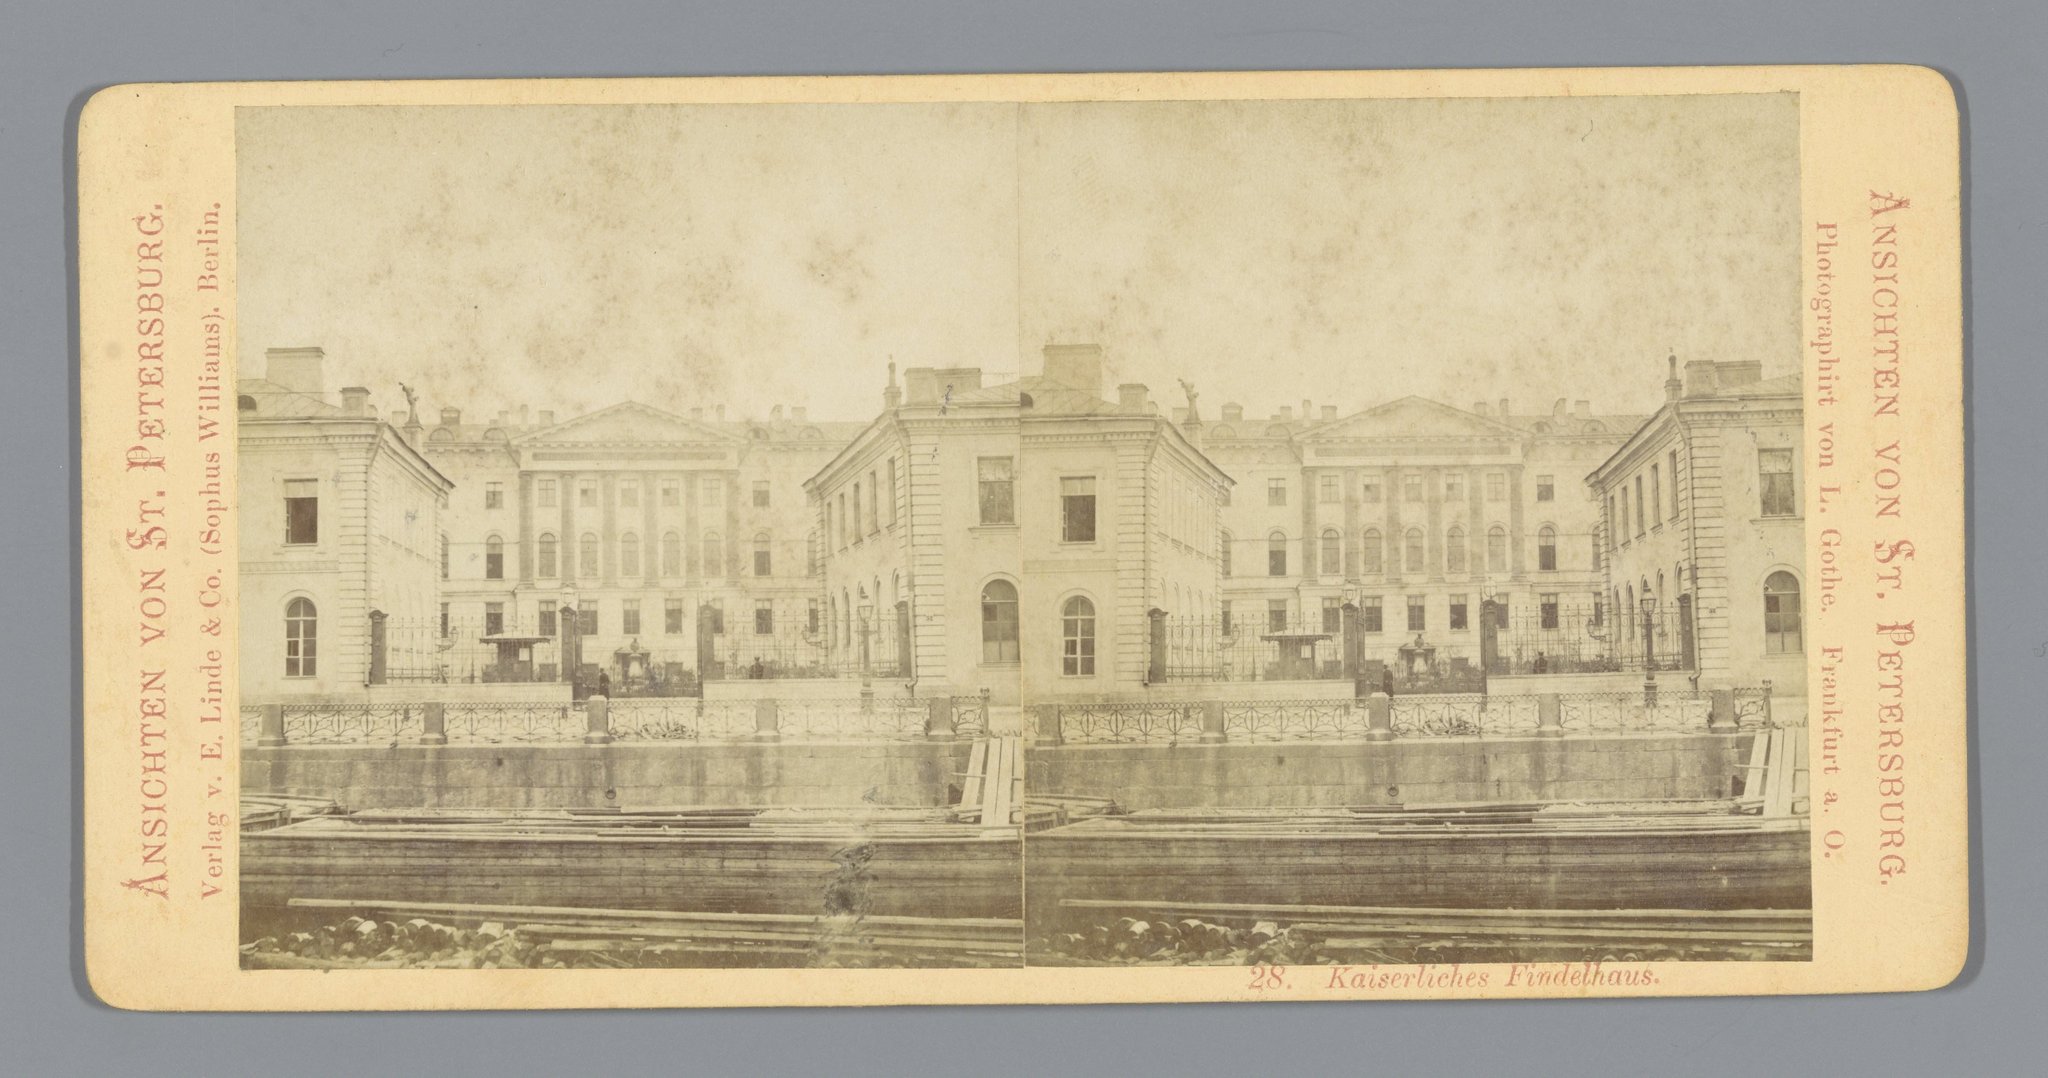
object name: stereograph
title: Kaiserliches Findelhaus.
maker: louis gothe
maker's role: fotograaf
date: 1850-1880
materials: cardboard, photographic support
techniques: albumen print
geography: sint-petersburg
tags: foundling-hospital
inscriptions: inscription: ‘Ansichten von St. Petersburg.’, number: ‘28.’